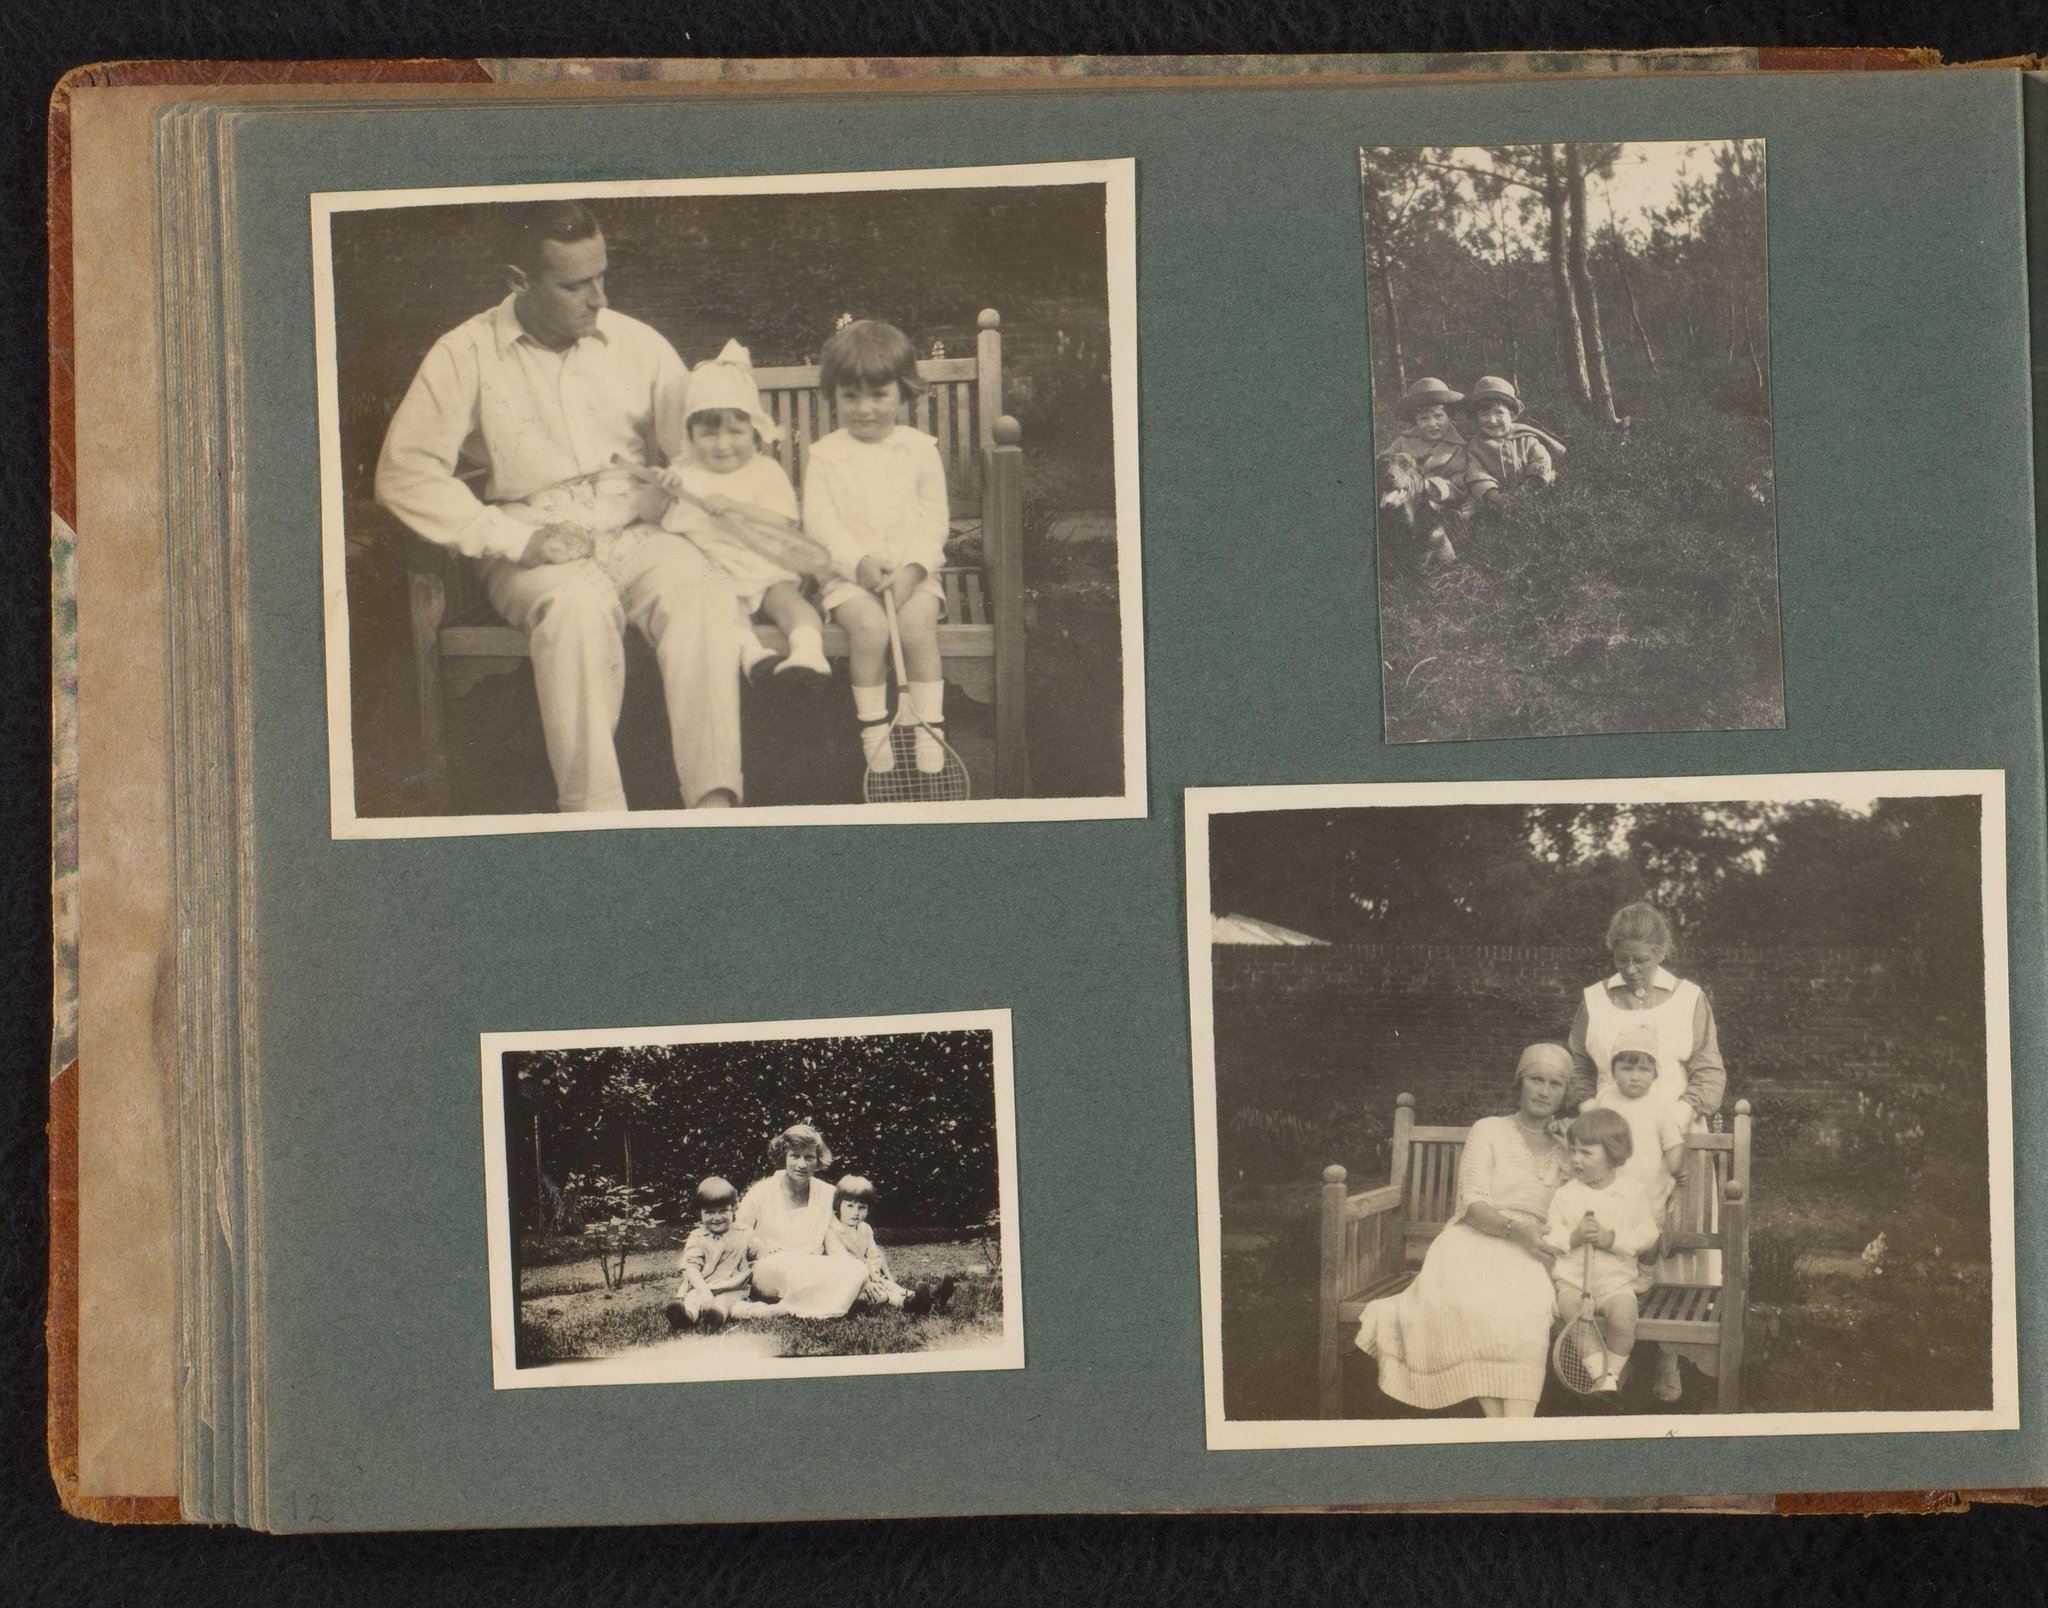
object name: album leaf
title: Vier foto's van ouders en twee kinderen, op een tuinbank en in het bos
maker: Anonymous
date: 1920-1930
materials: paper, cardboard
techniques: gelatin silver print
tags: the hague, parents with their children, garden, historical persons, forest, wood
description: Mogelijk Carolina Frederica Onnen, Frank Willem Tobias Furnée en Frank en Pieter Furnée.